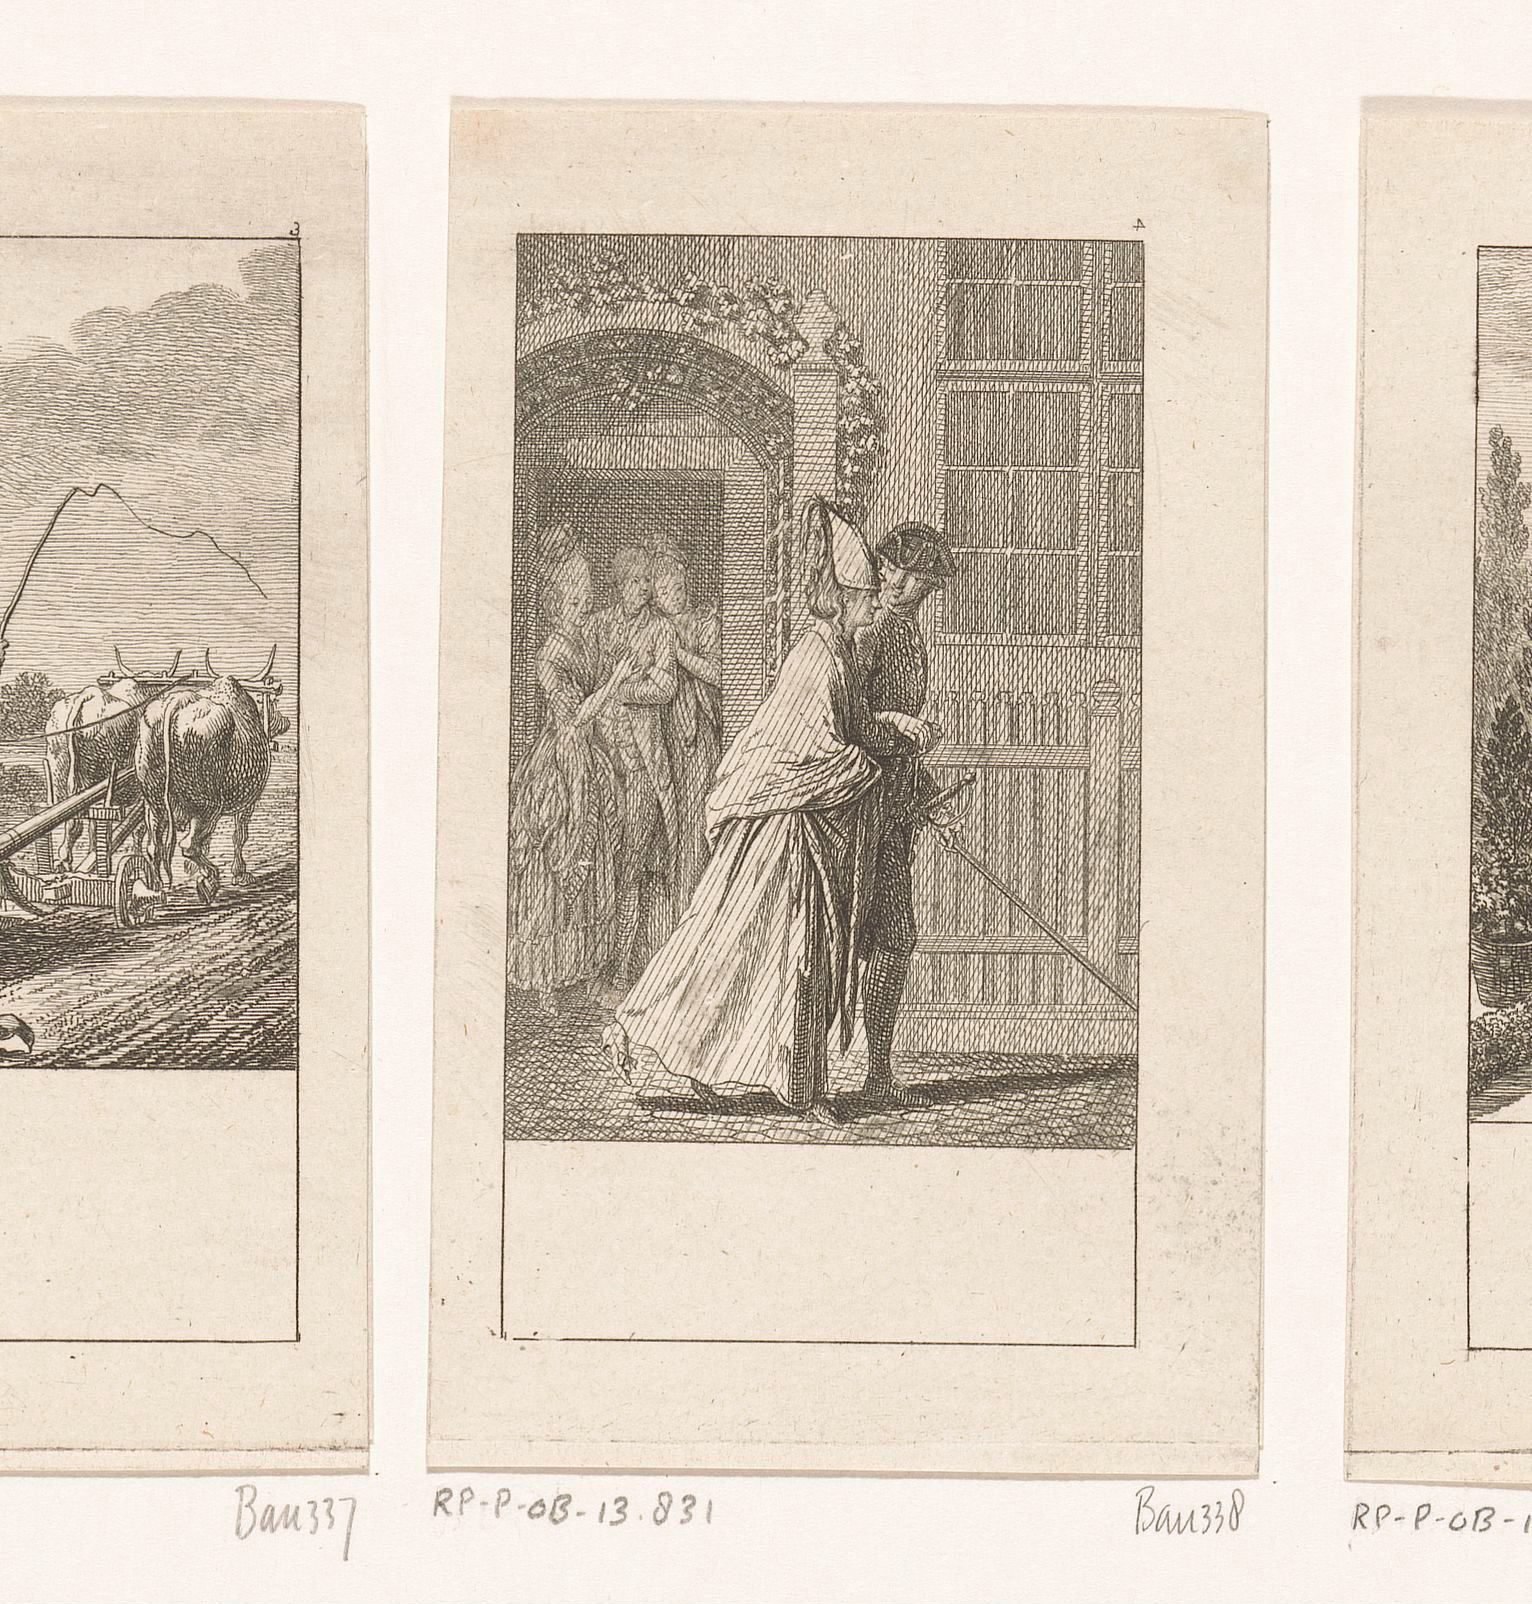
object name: print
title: April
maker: daniel nikolaus chodowiecki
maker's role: draughtsman, print maker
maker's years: 1726-1801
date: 1777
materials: paper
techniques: etching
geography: berlin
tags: downpour, rain shower, april and its 'labours'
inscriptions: collector's mark: Lugt 2228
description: Afkomstig uit een serie met de twaalf maanden. Deze serie werd op een plaat geëtst. Een latere staat van deze serie werd gebruikt in: Königl. Großbrit. Churf. Braunschw. Lüneb. Genealogischen Kalender, auf das Jahr 1778. Lauenburg: Johann Georg Berenberg.